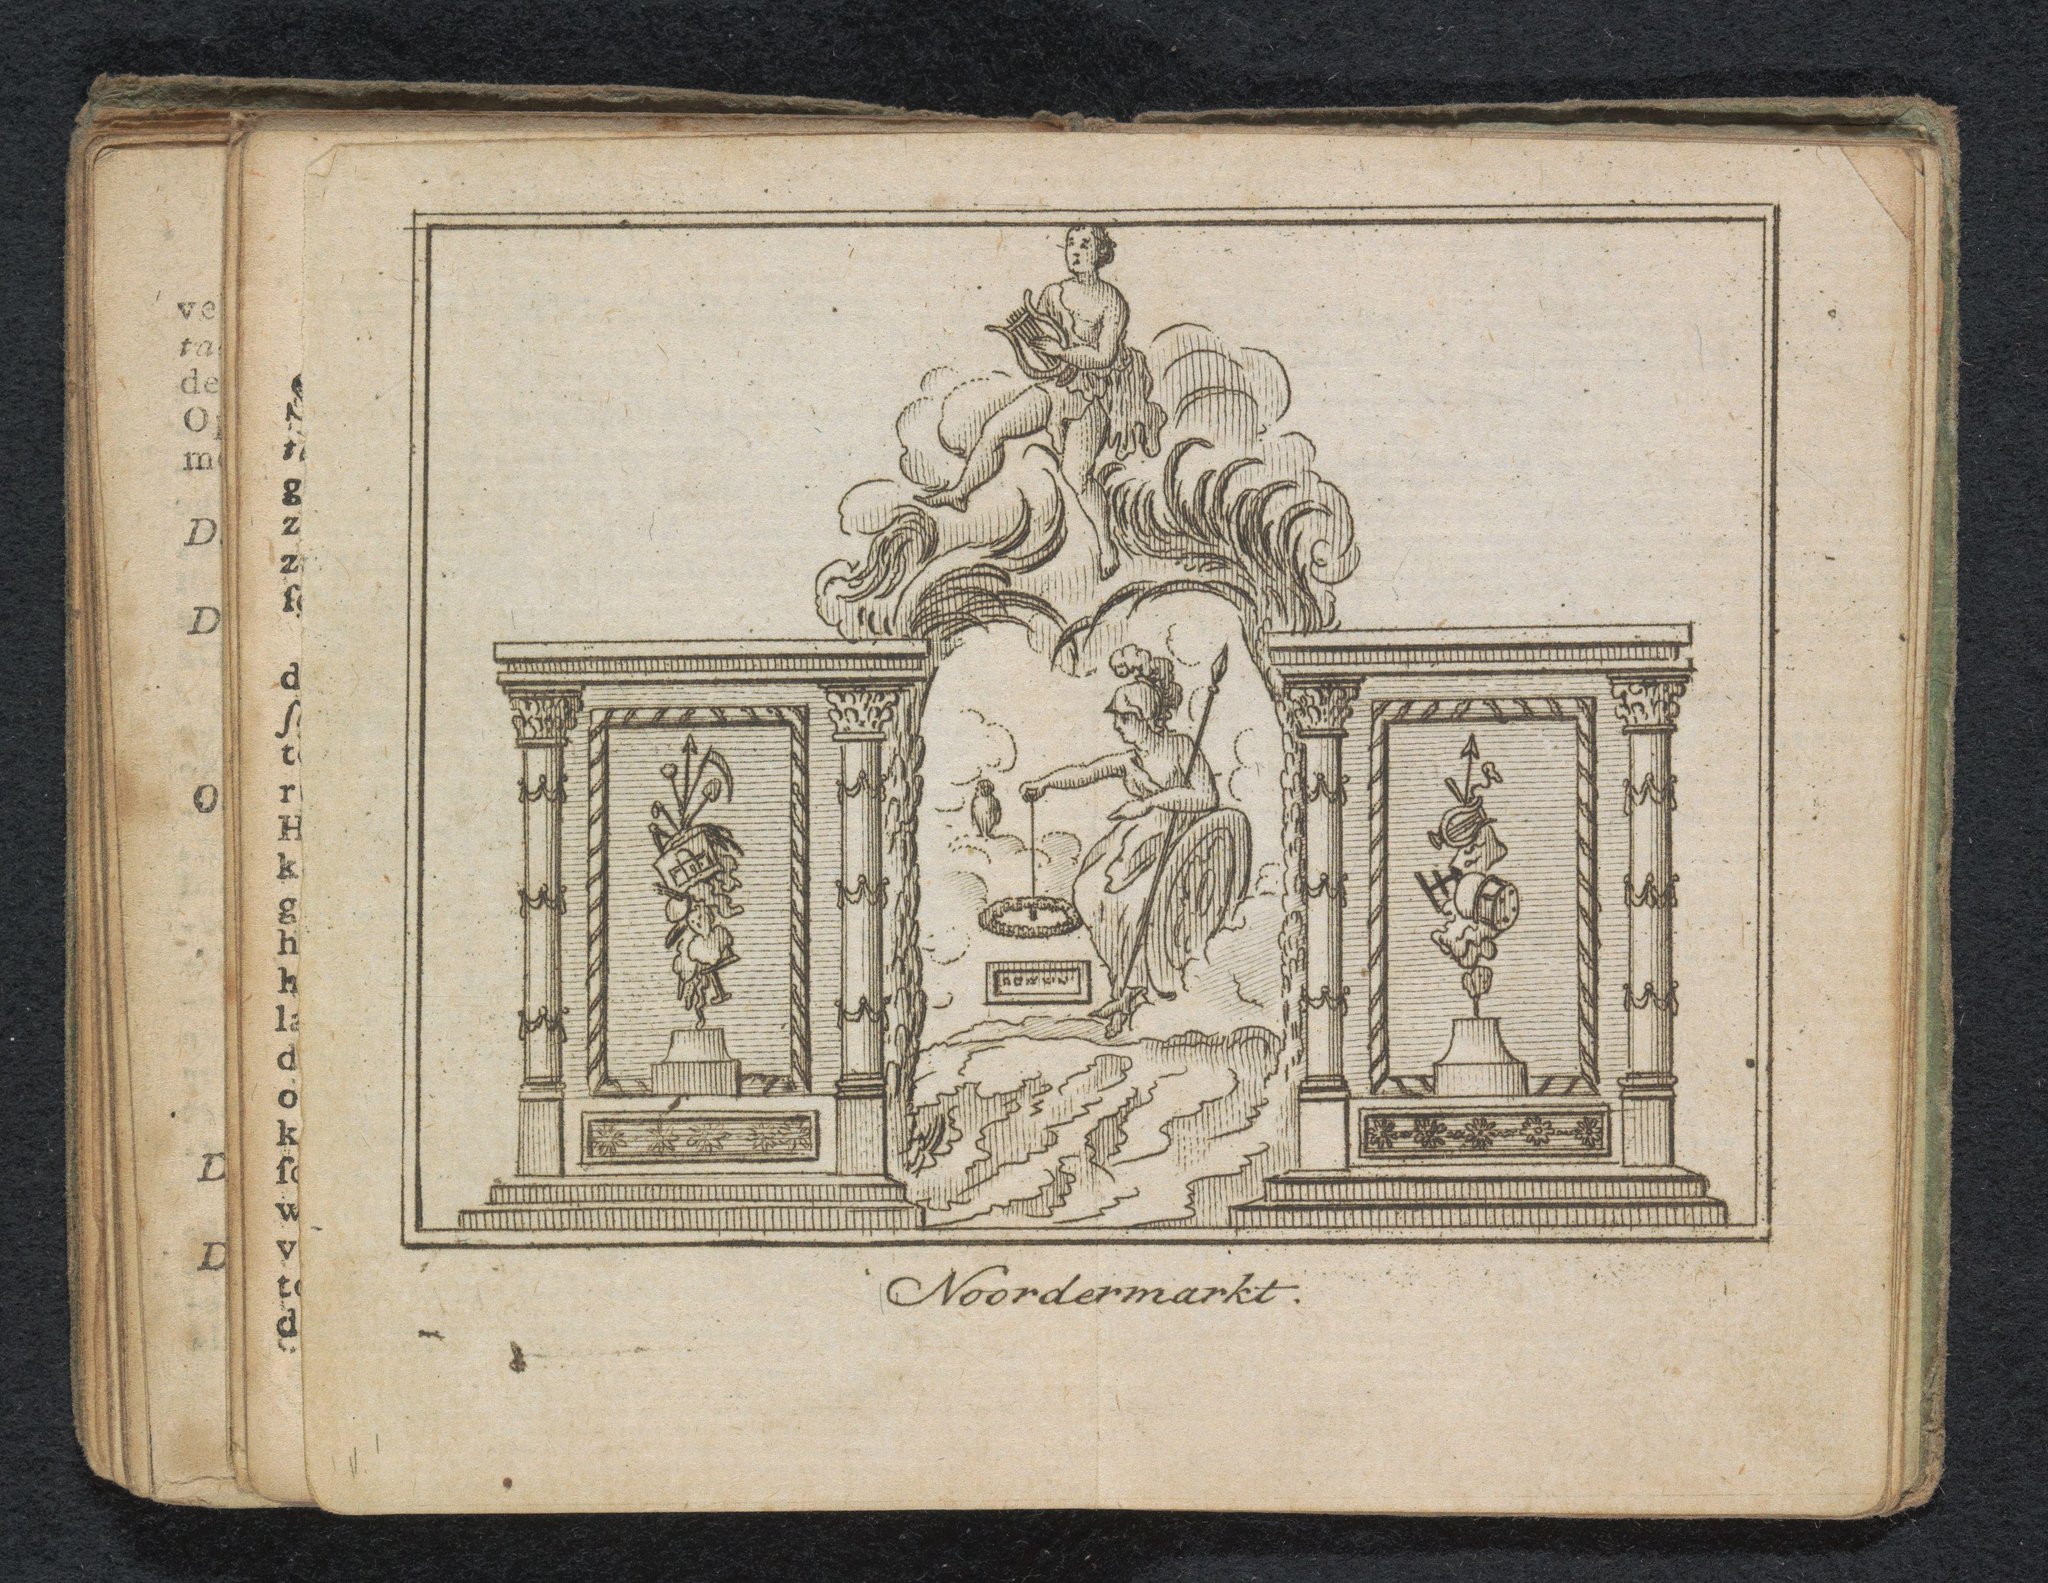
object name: print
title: Kunsten en Wetenschappen, decoratie op de Noordermarkt, 1795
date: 1795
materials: paper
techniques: etching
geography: amsterdam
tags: specific aspects, allegorical aspects of minerva; minerva as patroness, festivities on events of national importance (+ festive decoration ~ festive activities), equality, equity, fairness, righteousness; 'equalità', 'equità', 'giuditio giusto', 'ordine dritto e giusto', 'ugualità' (ripa) (+ symbolical representation of concept), alliance with france (1795)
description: Kunsten en Wetenschappen, allegorische decoratie opgericht op de Noordermarkt te Amsterdam bij het Alliantiefeest op 19 juni 1795. Minerva zittend in de wolken met schietlood (Gelijkheid) boven een krans en vuur. Bovenaan Apollo spelend op de lier. Illustratie in het Bataafsche revolutie- en alliantie almanach voor 1796.